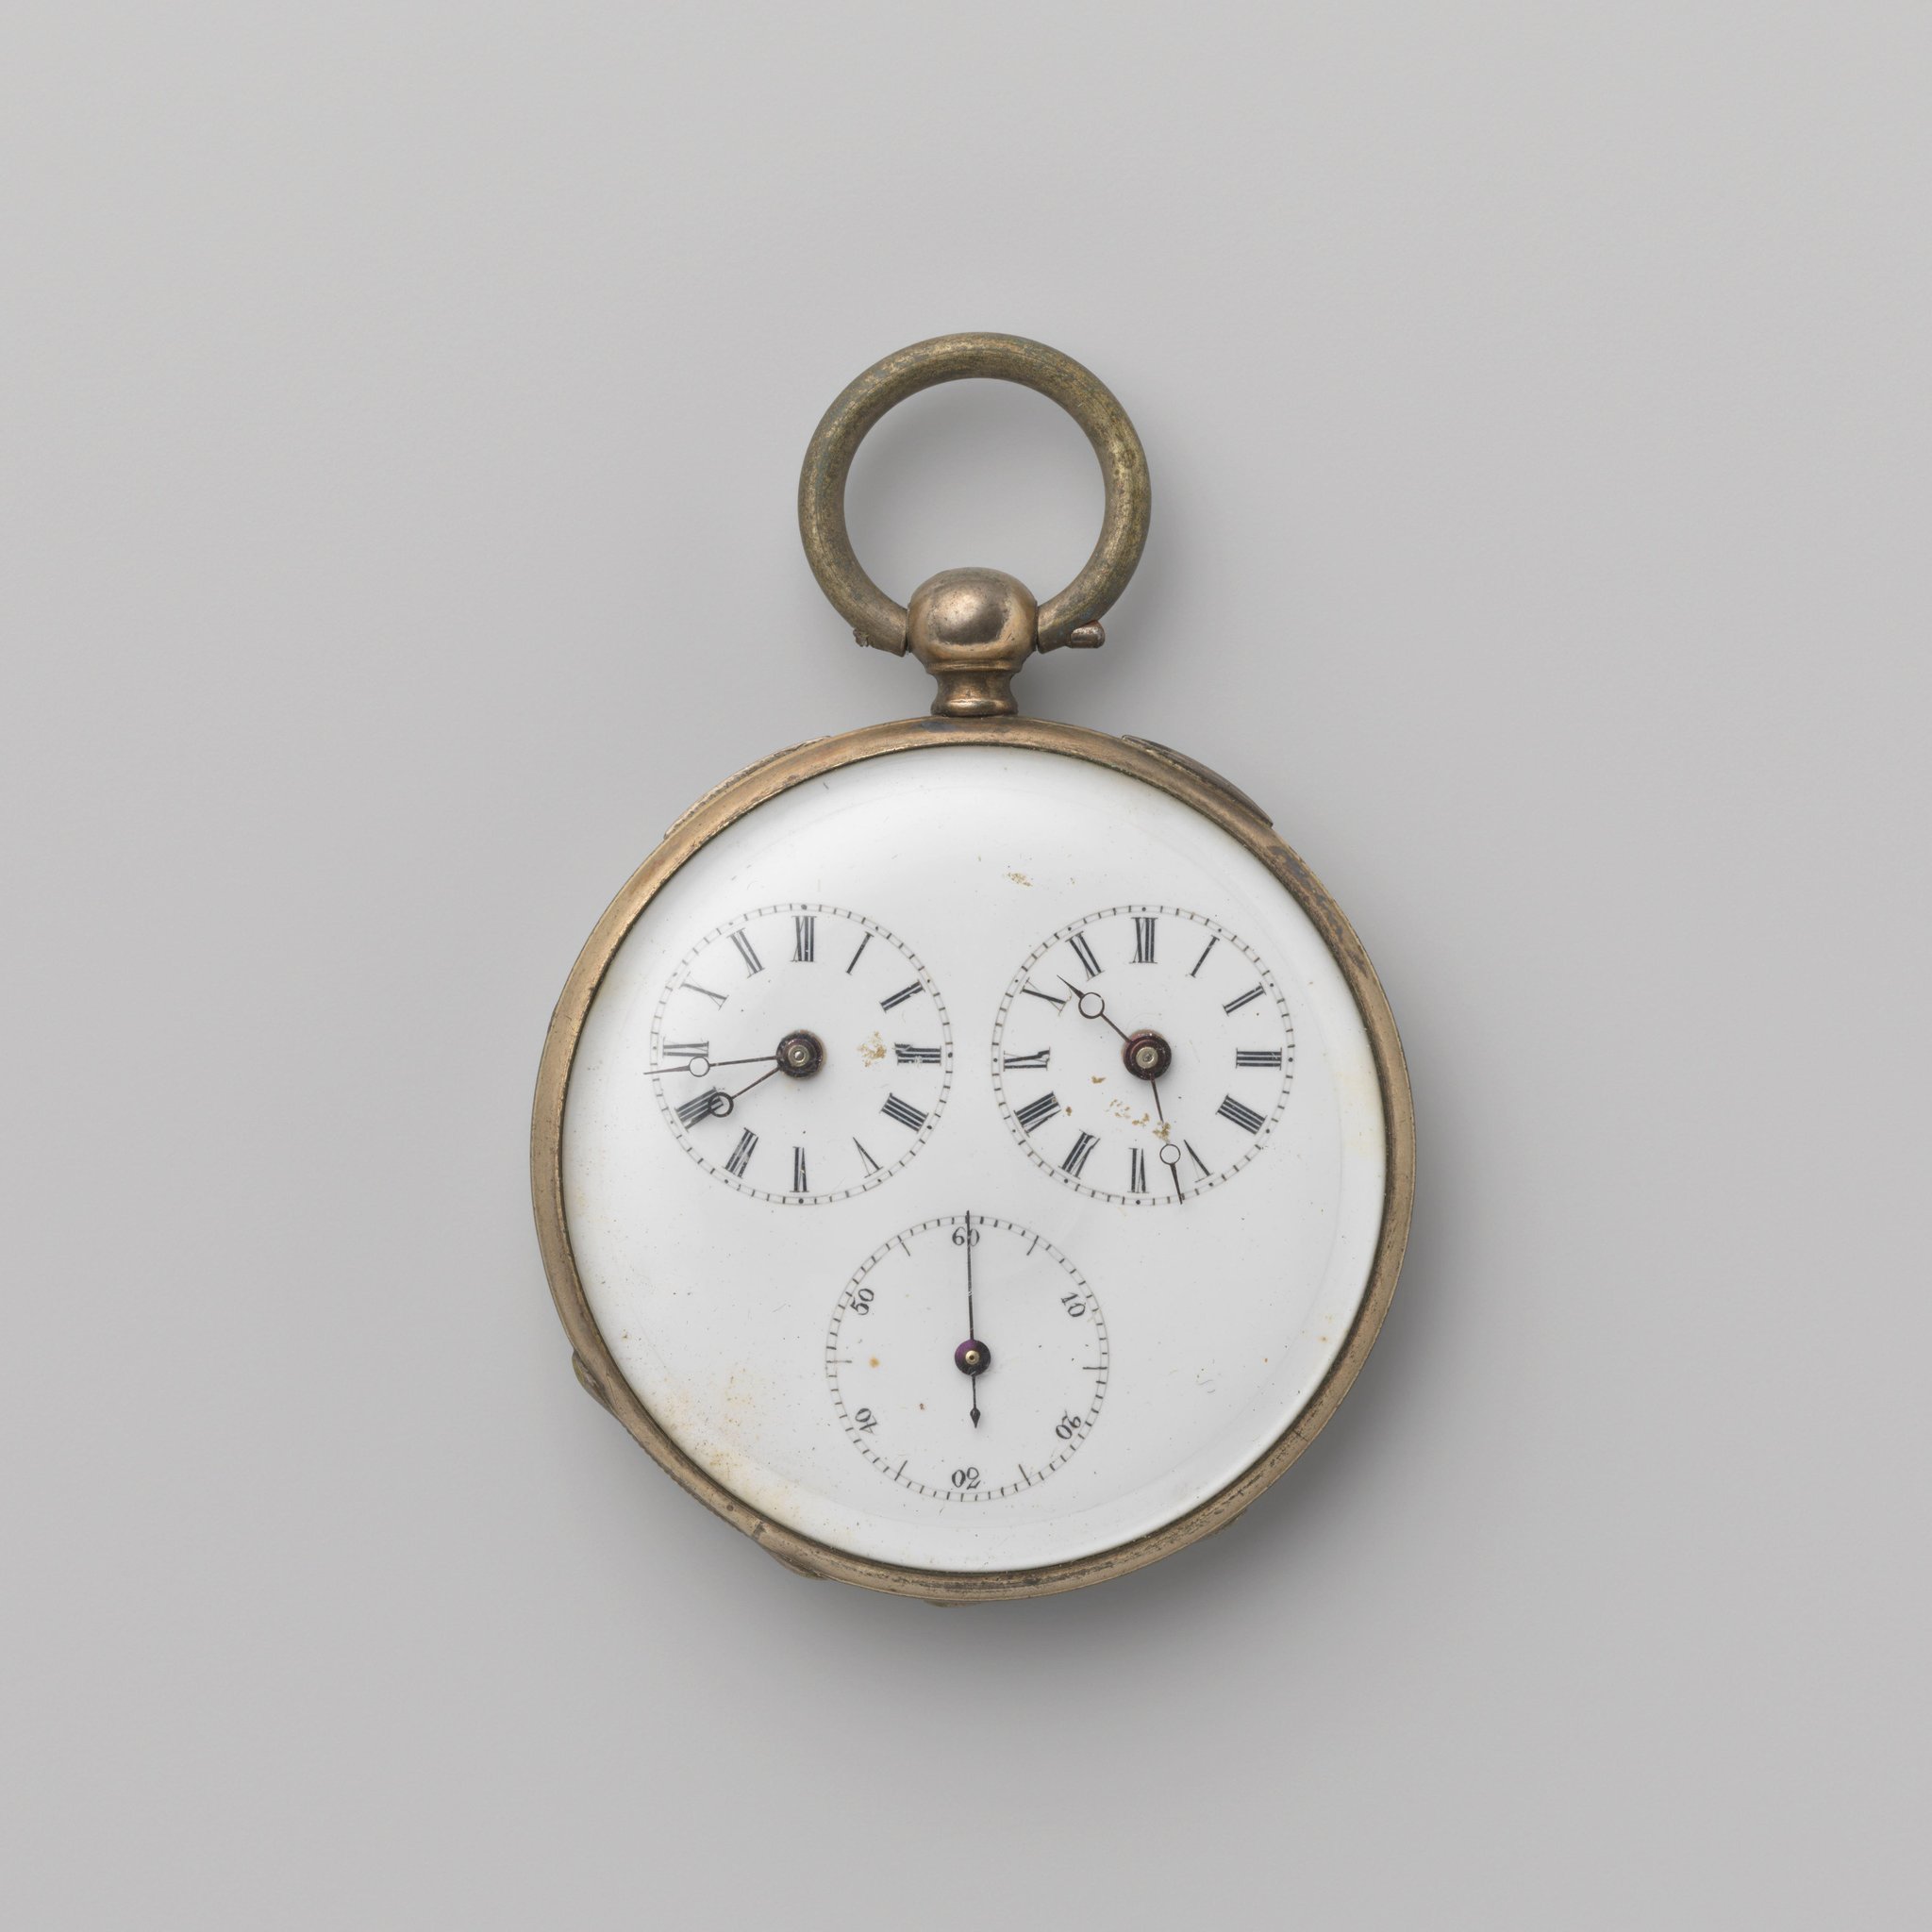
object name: wrist watch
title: Horloge van zilver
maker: Anonymous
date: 1800-1900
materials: silver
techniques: enameling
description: Horloge van zilver, met cylindergang en met een witgeëmailleerde wijzerplaat. Hierop 2 cijferingen met Romeinse cijfers en 1 met Arabische cijfers.